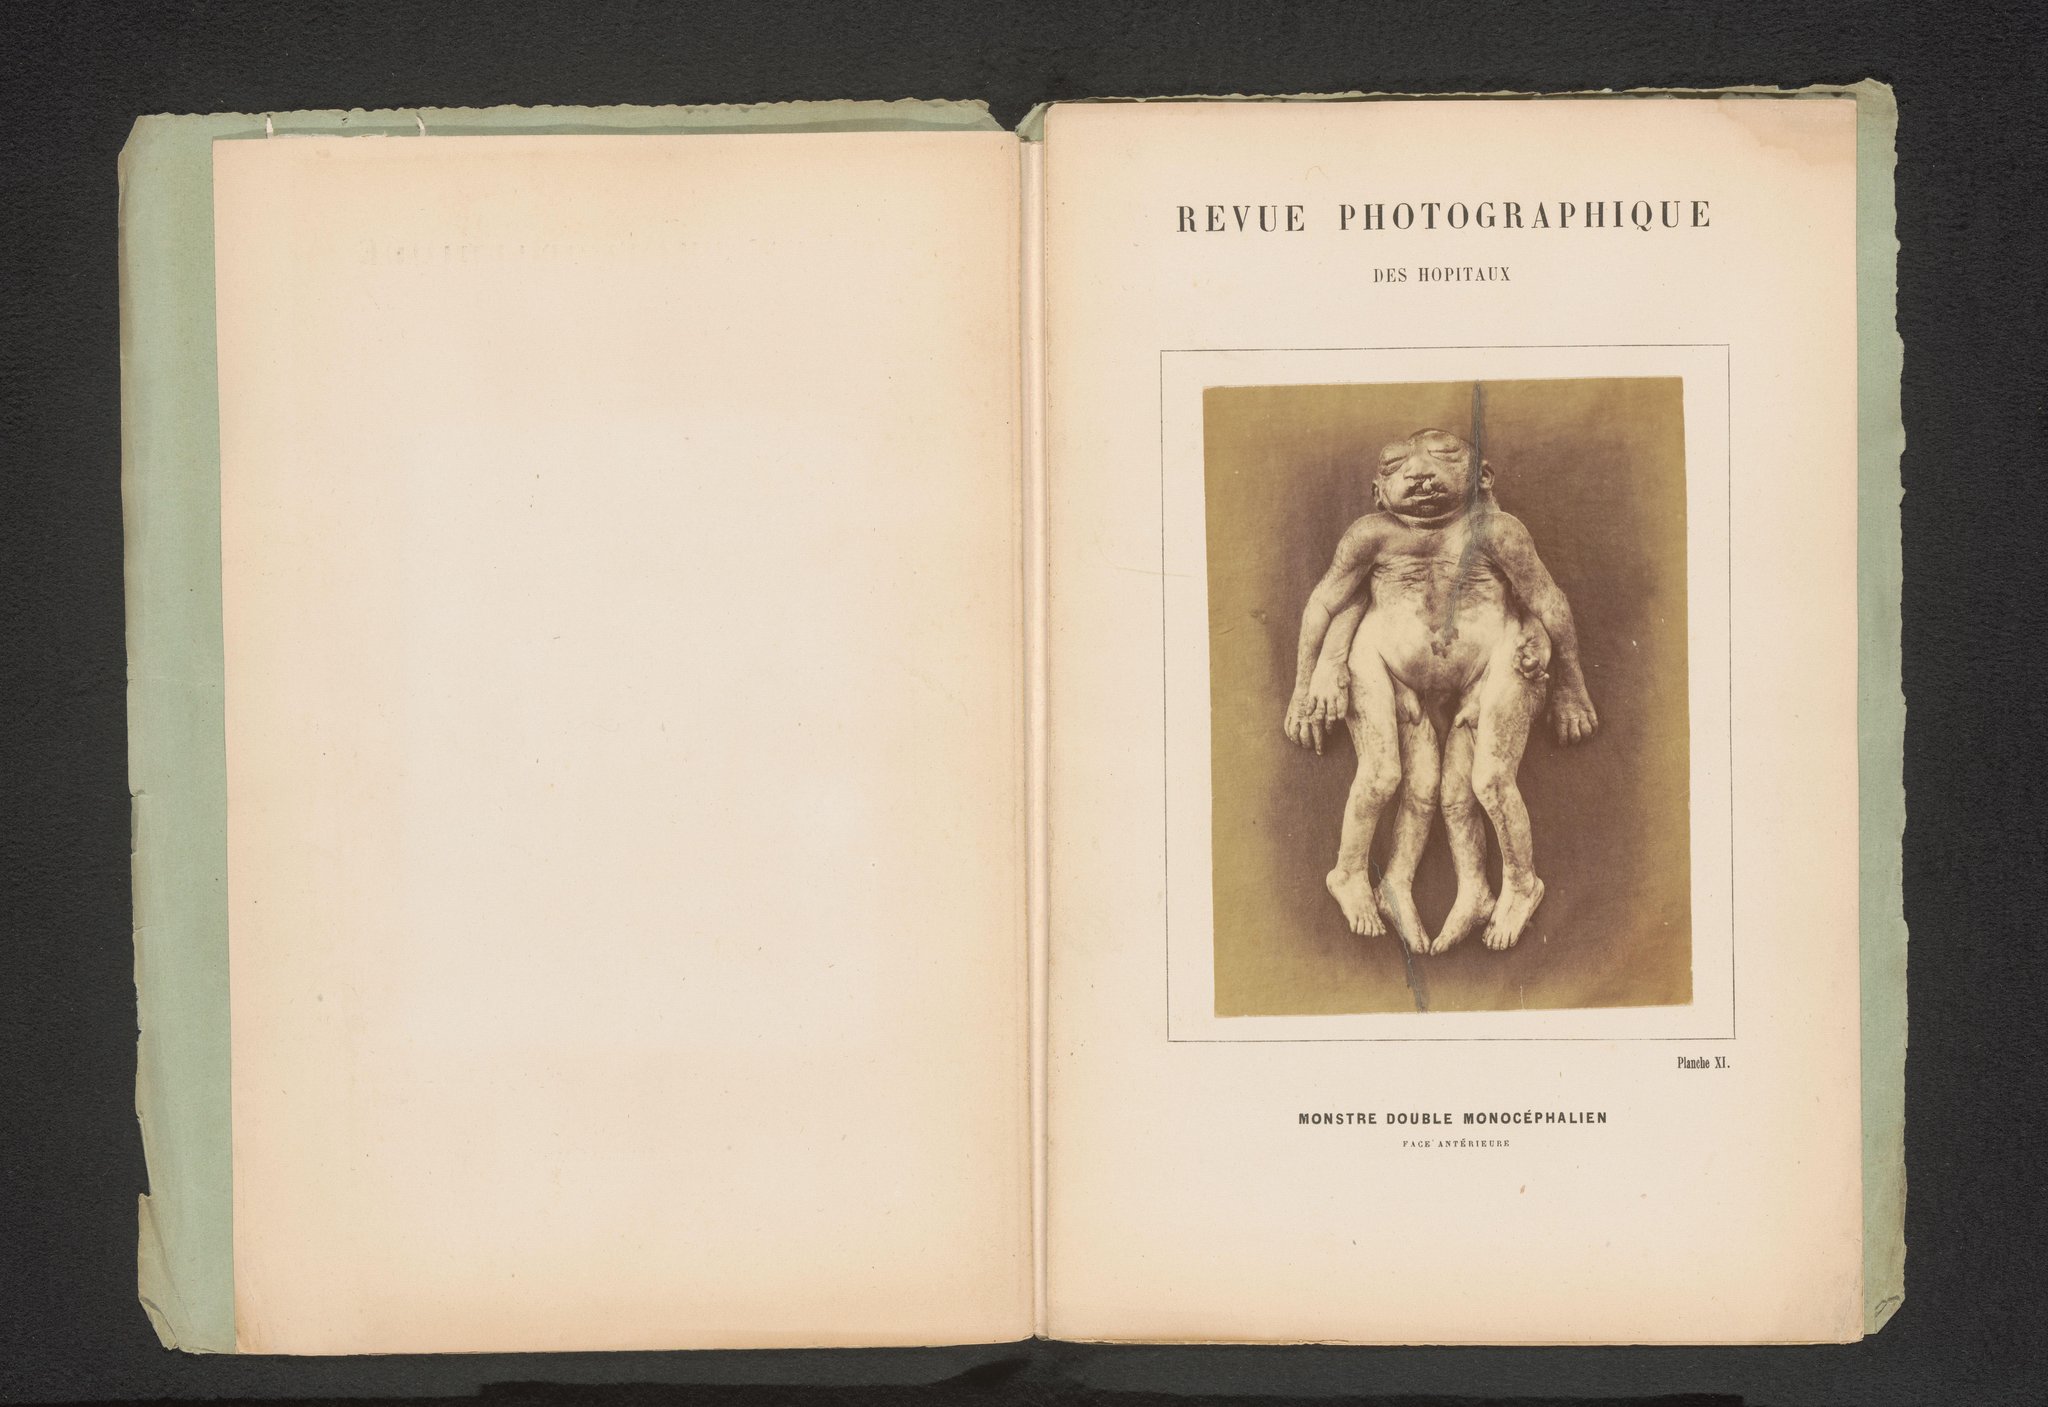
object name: page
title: Twee met elkaar vergroeide lichamen met één hoofd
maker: Anonymous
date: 1865-1870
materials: paper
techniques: albumen print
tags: medical research, branches of medicine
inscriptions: inscription: ‘Revue photographique/ des hopitaux/ Planche XI.’